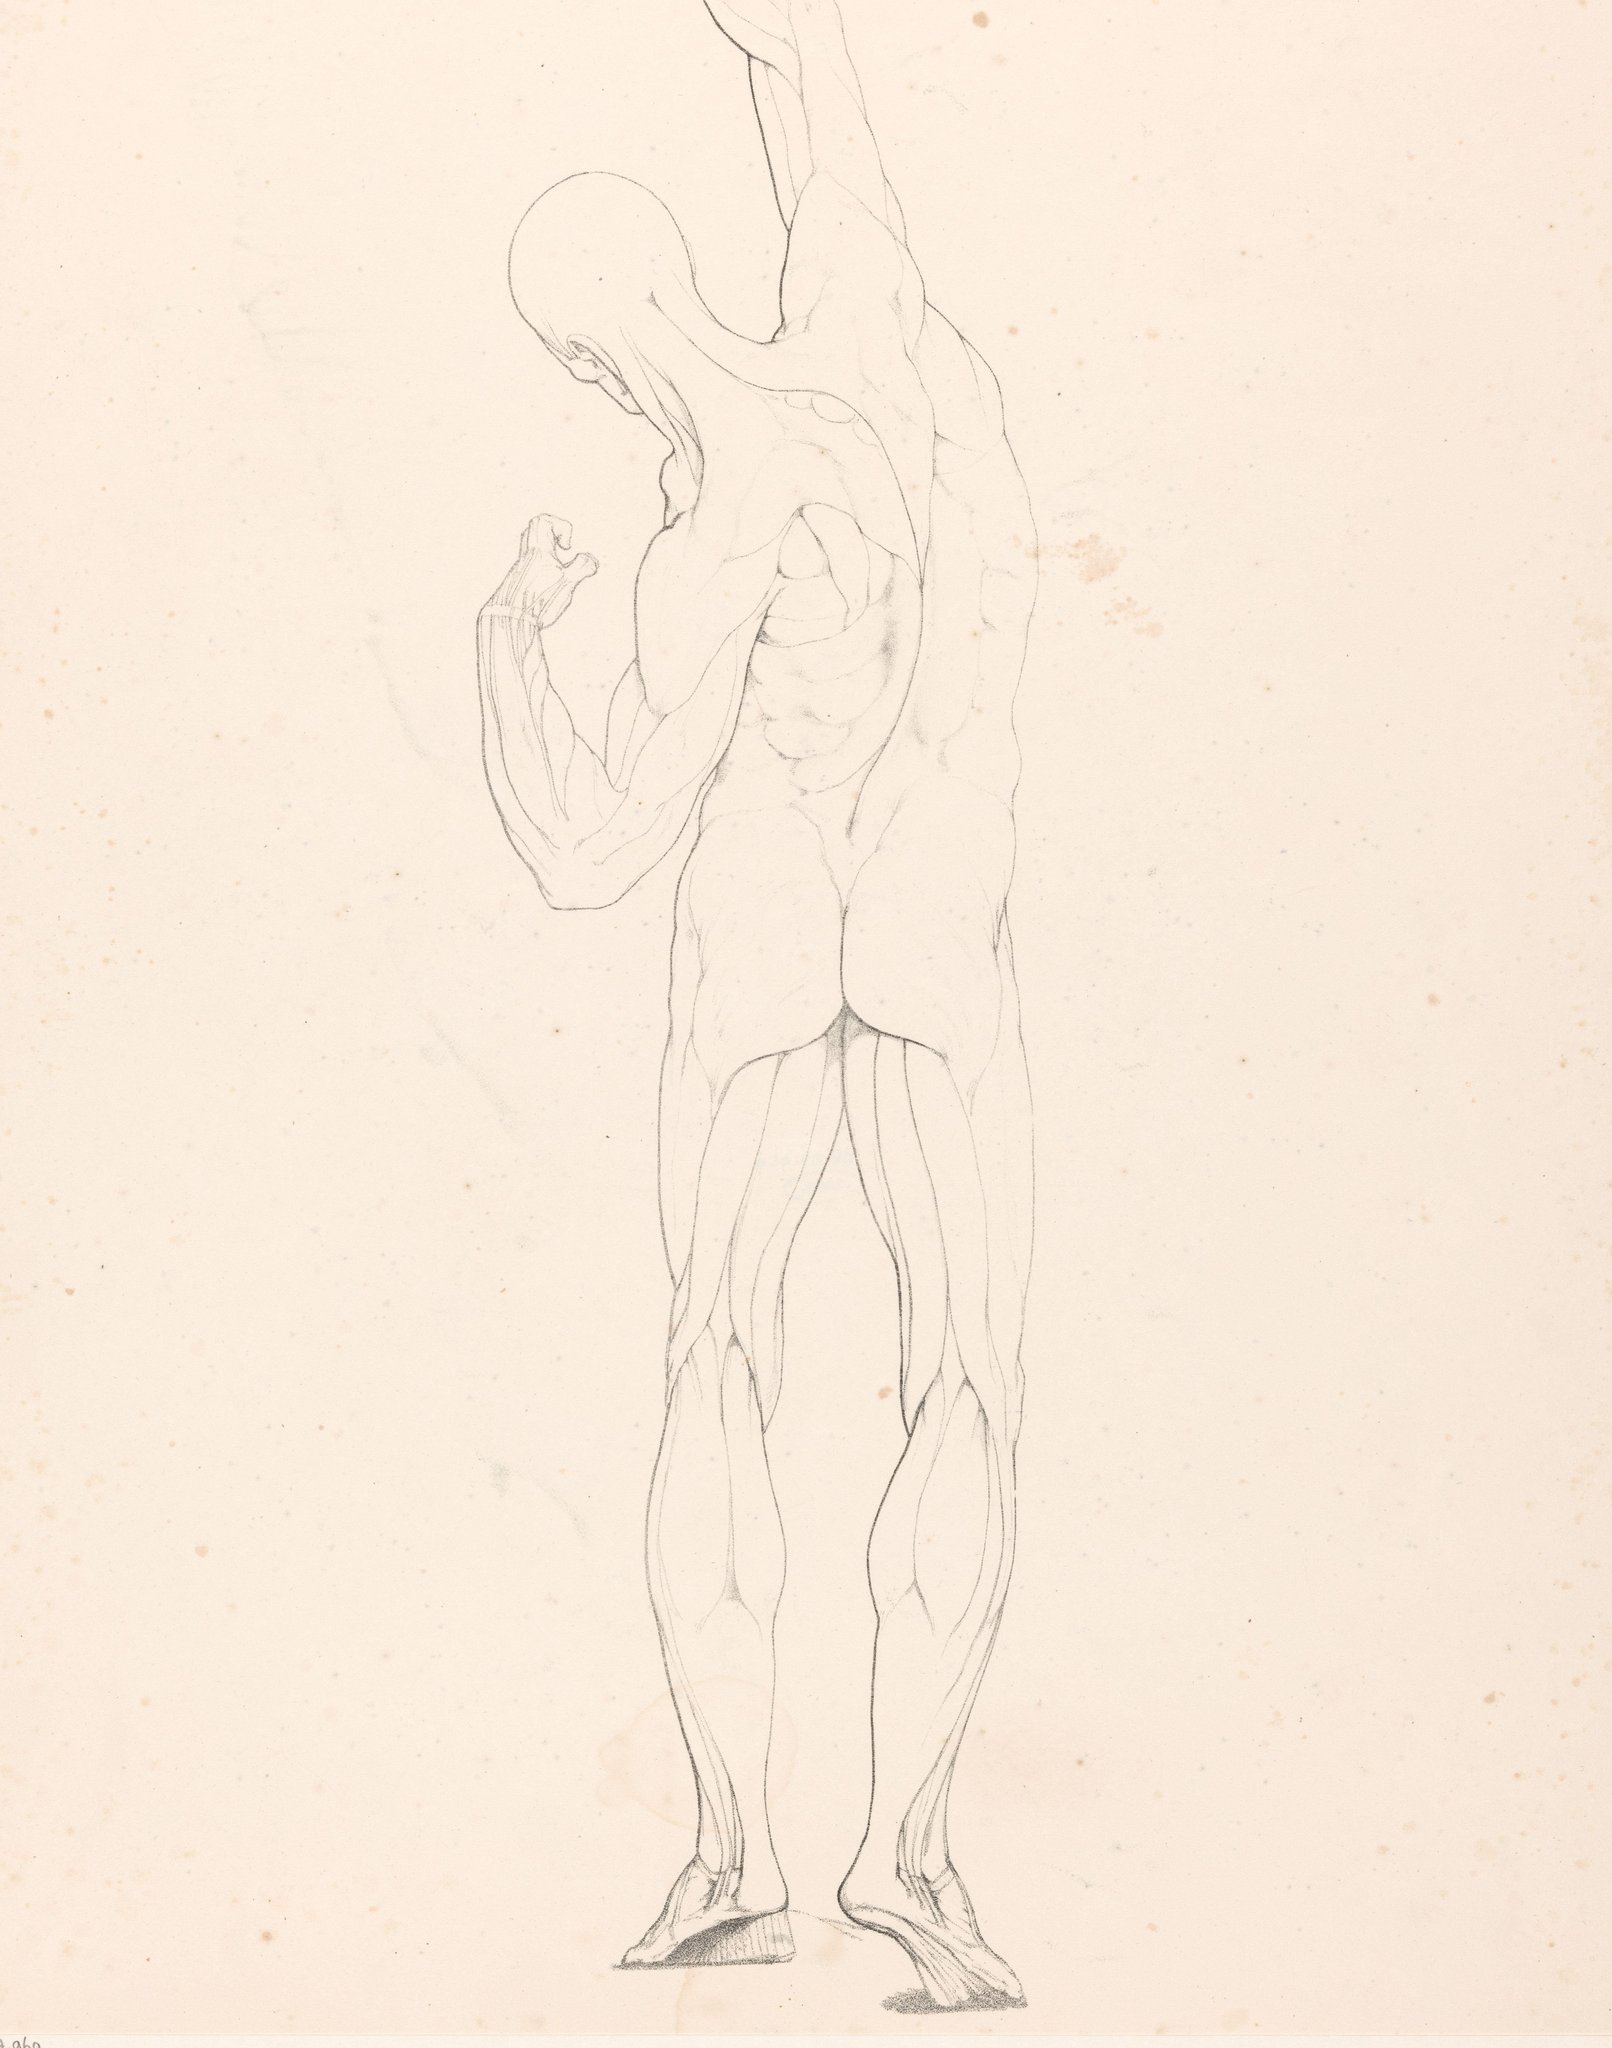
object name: print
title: Tekenvoorbeeld van een écorché op de rug gezien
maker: jean augustin daiwaille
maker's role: draughtsman, print maker, printer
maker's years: 1786-1850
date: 1820-1833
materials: paper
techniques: lithograph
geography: amsterdam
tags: anatomical model of the muscles, muscle-man, 'écorché', arms raised, with fingers closed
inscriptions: collector's mark: Lugt 2228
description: De man heeft zijn rechterarm naar boven uitgestrekt, zijn bovenlichaam is naar links gedraaid.